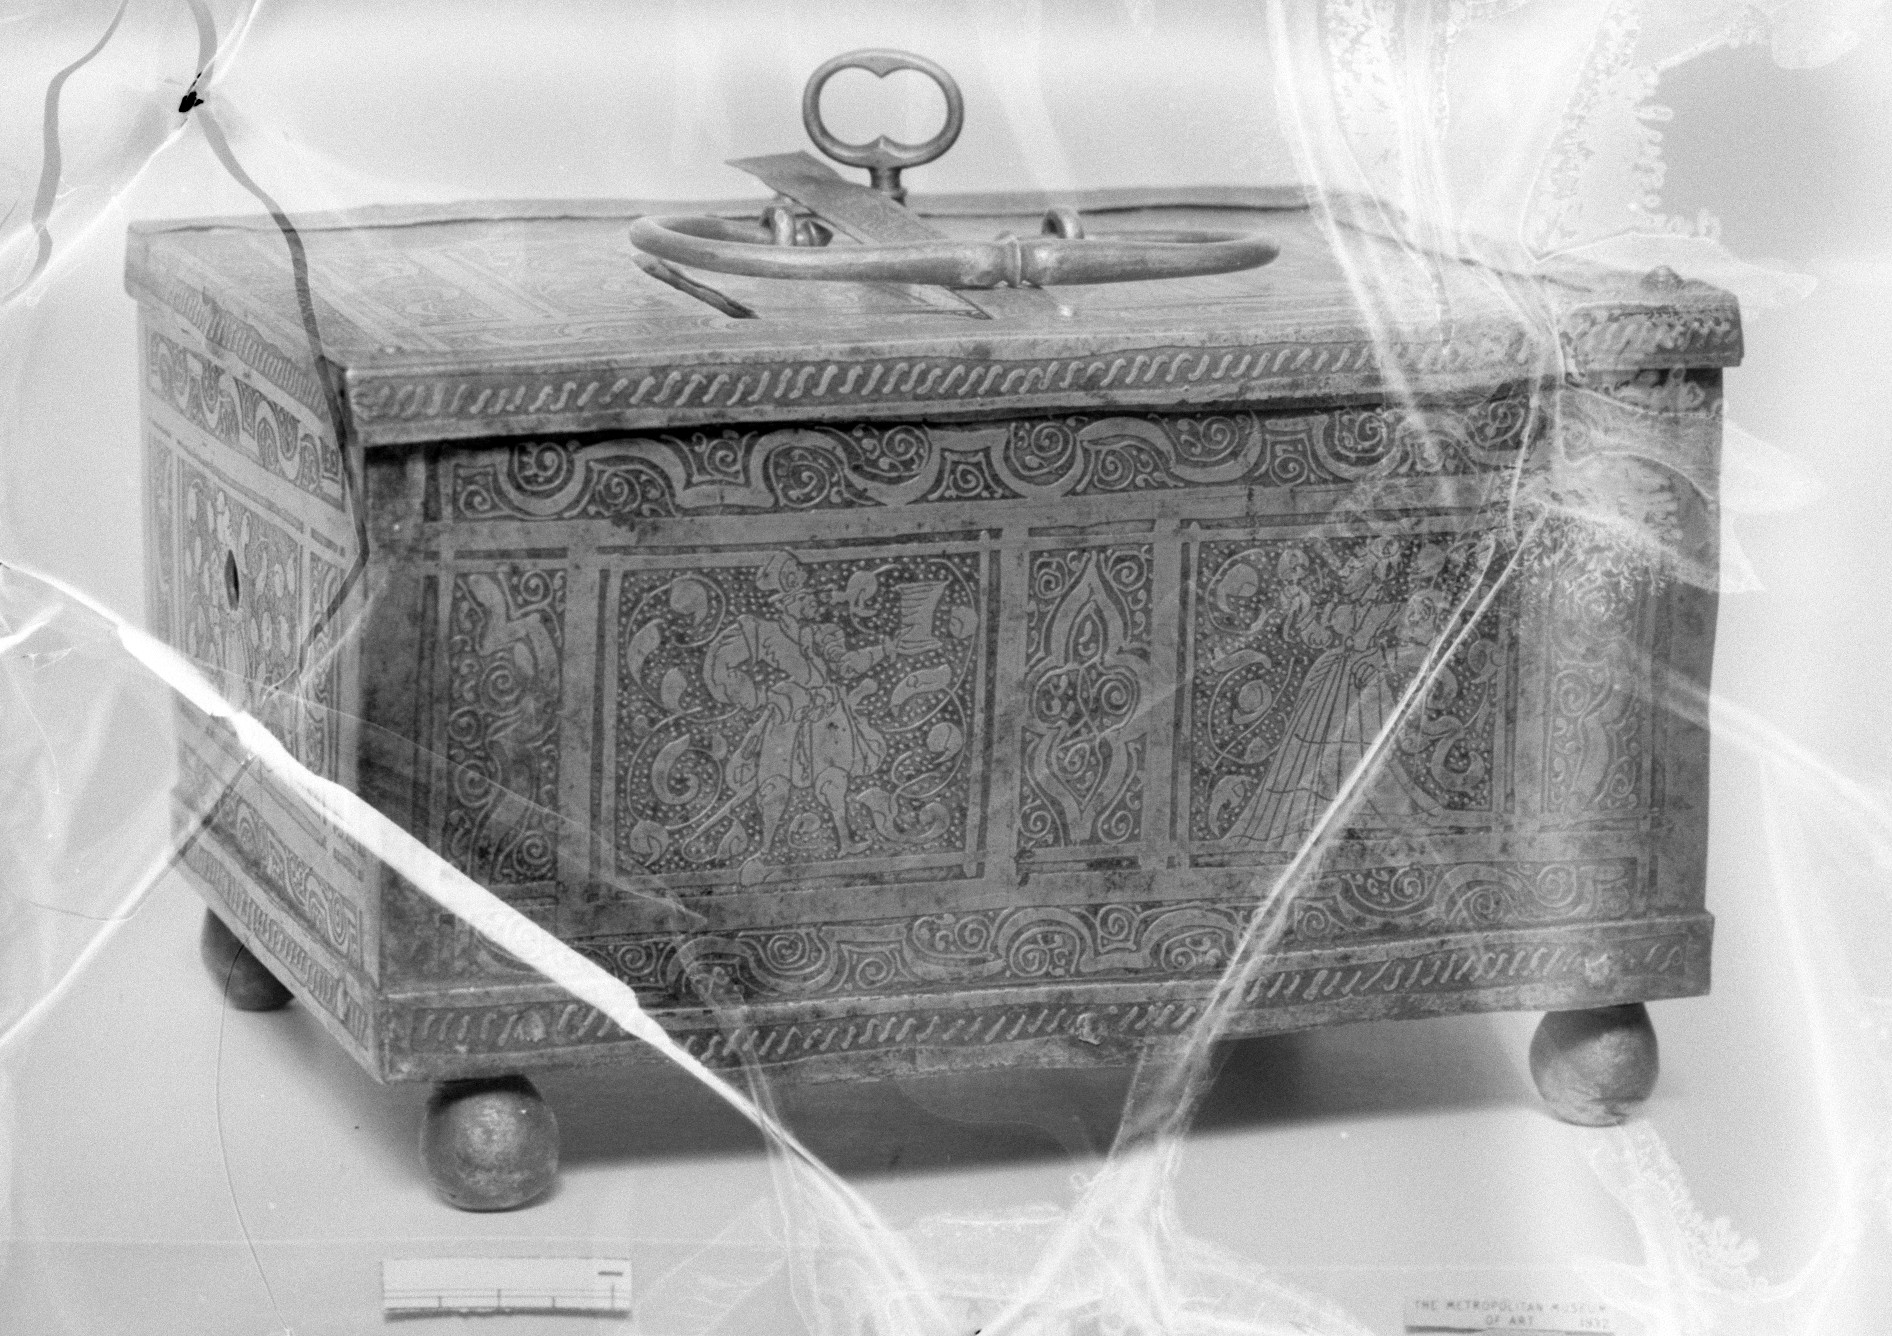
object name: casket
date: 1570-1600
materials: iron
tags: men,women